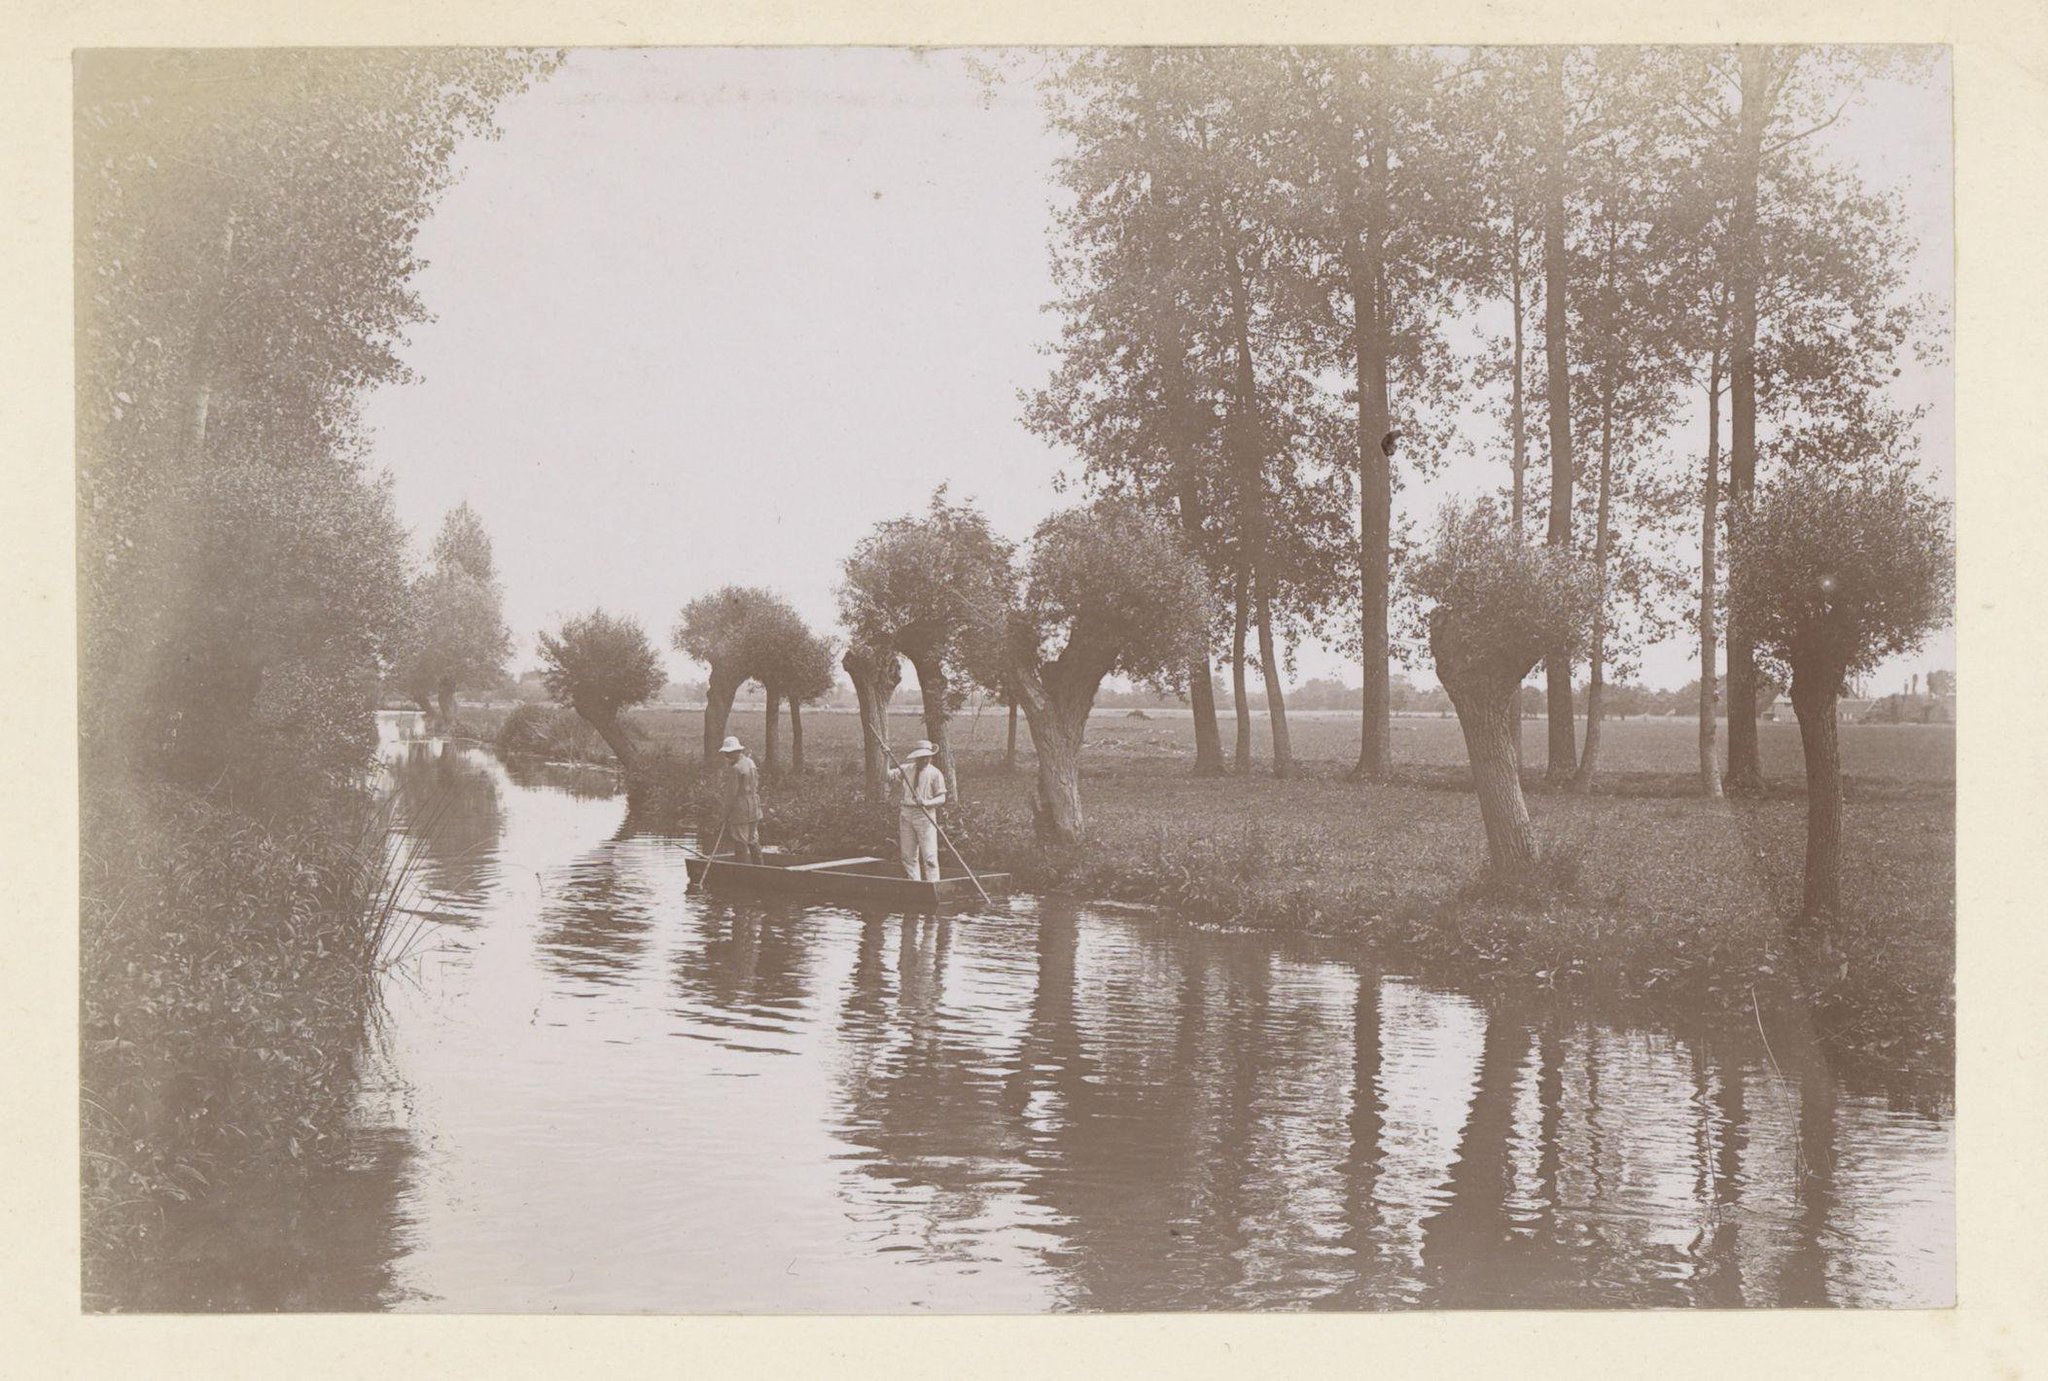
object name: photograph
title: Mannen op een boot, vermoedelijk in een sloot in Frankrijk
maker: Anonymous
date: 1900-1910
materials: paper, photographic support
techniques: daylight paper print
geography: france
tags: poling, punting, trees: willow, small canal, ditch, france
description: Onderdeel van Fotoalbum van een Franse amateurfotograaf met opnames van een familie, distilleerderij Delizy & Doistau Fils, het leger en bezienswaardigheden in Frankrijk.